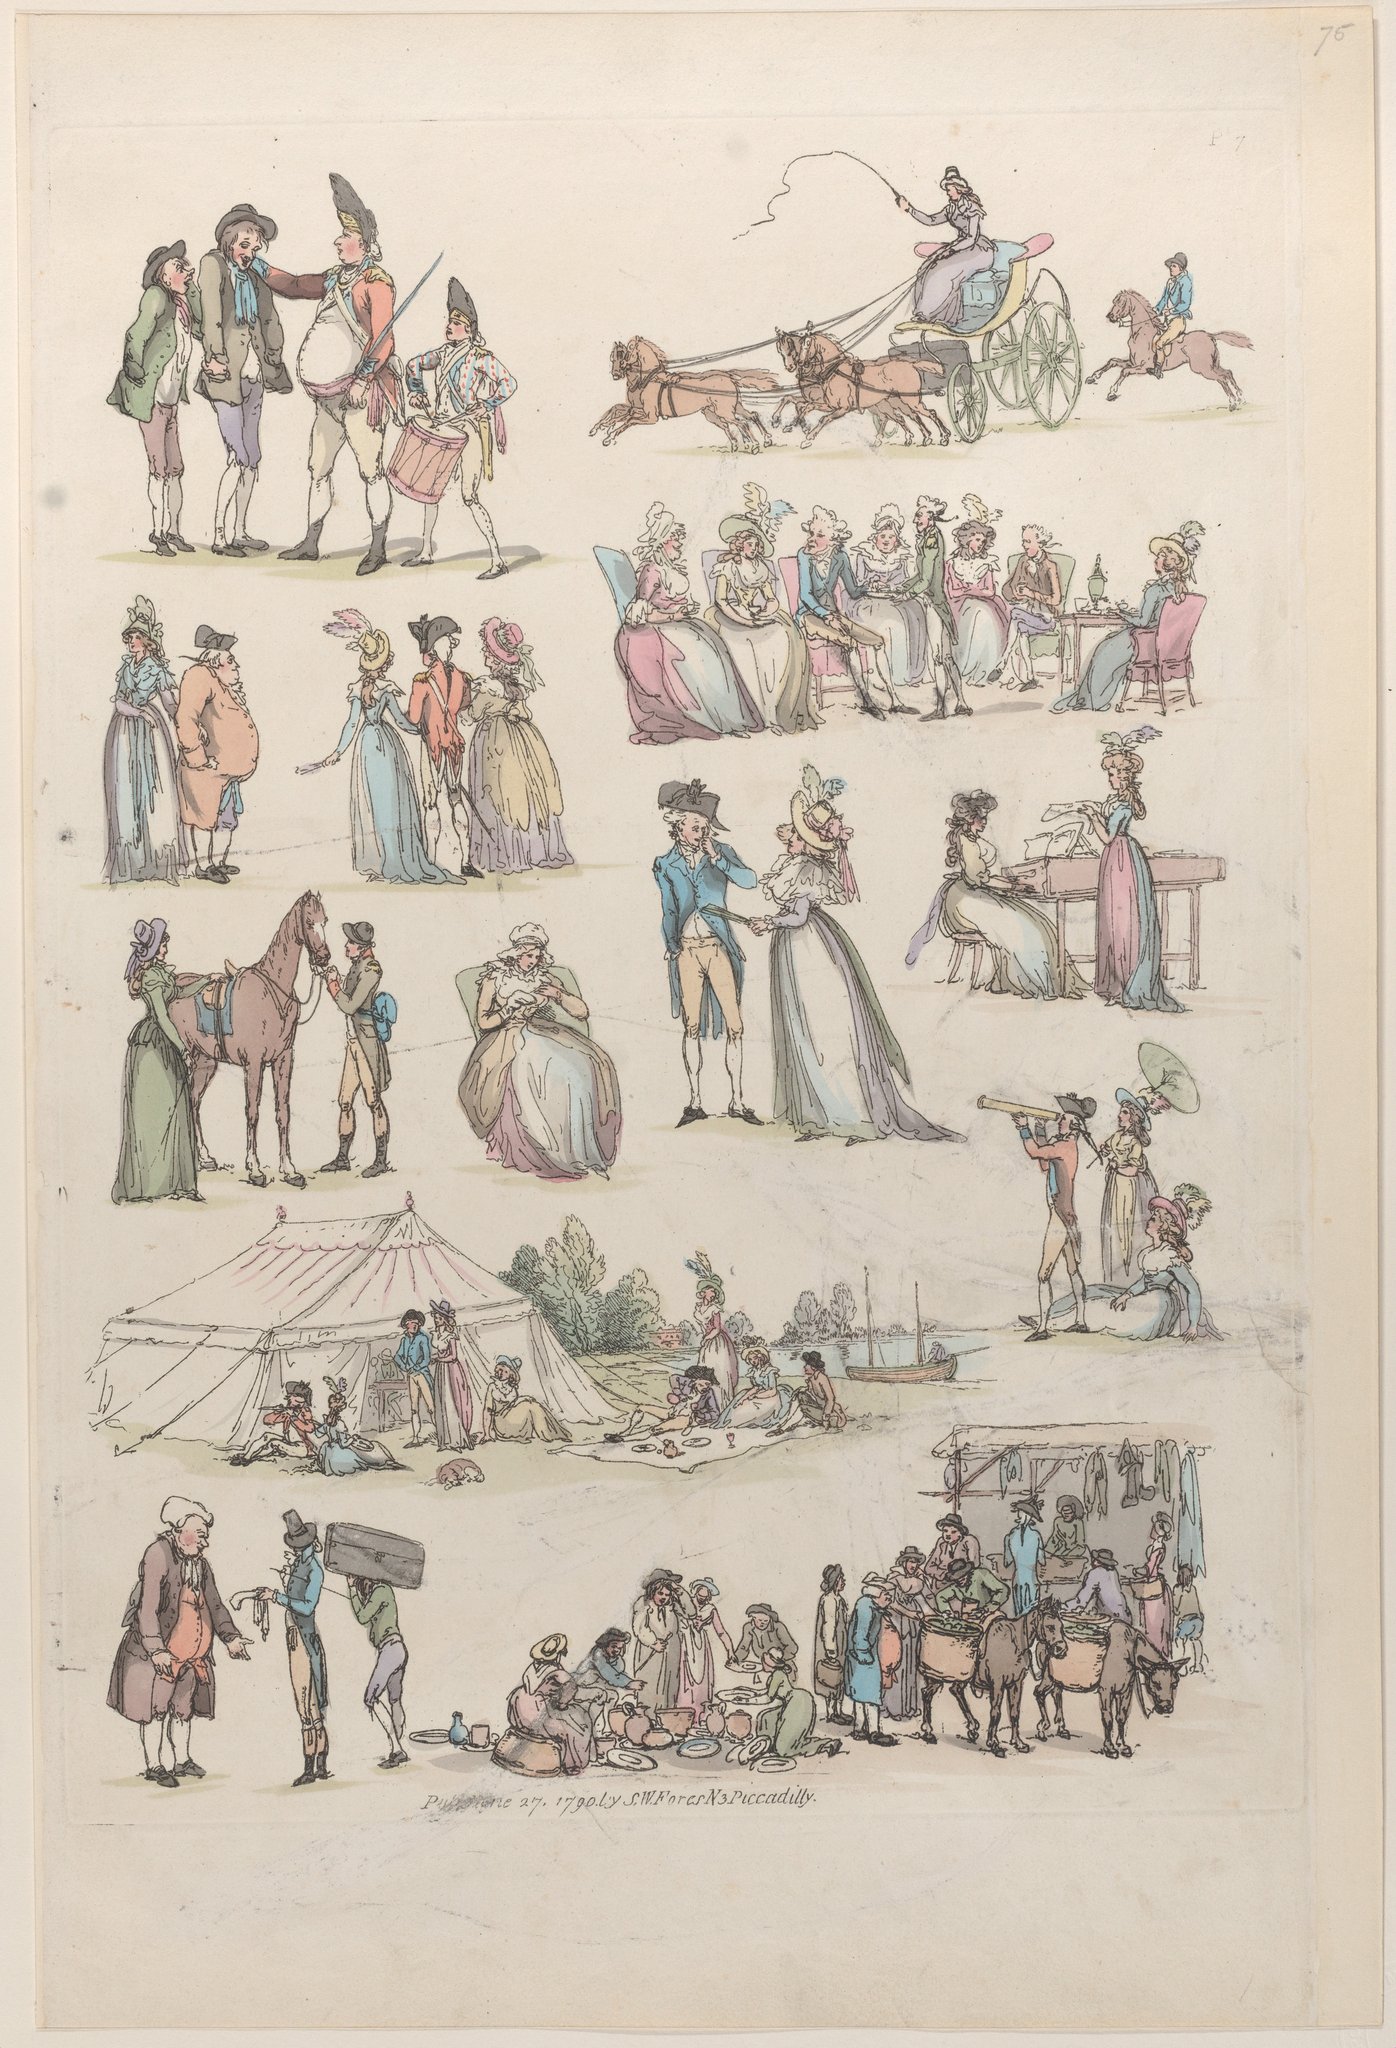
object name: print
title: Plate 7, Outlines of Figures, Landscapes and Cattle...for the Use of Learners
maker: thomas rowlandson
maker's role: artist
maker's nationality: british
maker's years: 1757-1827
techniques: etching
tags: men,women,horses,carriages